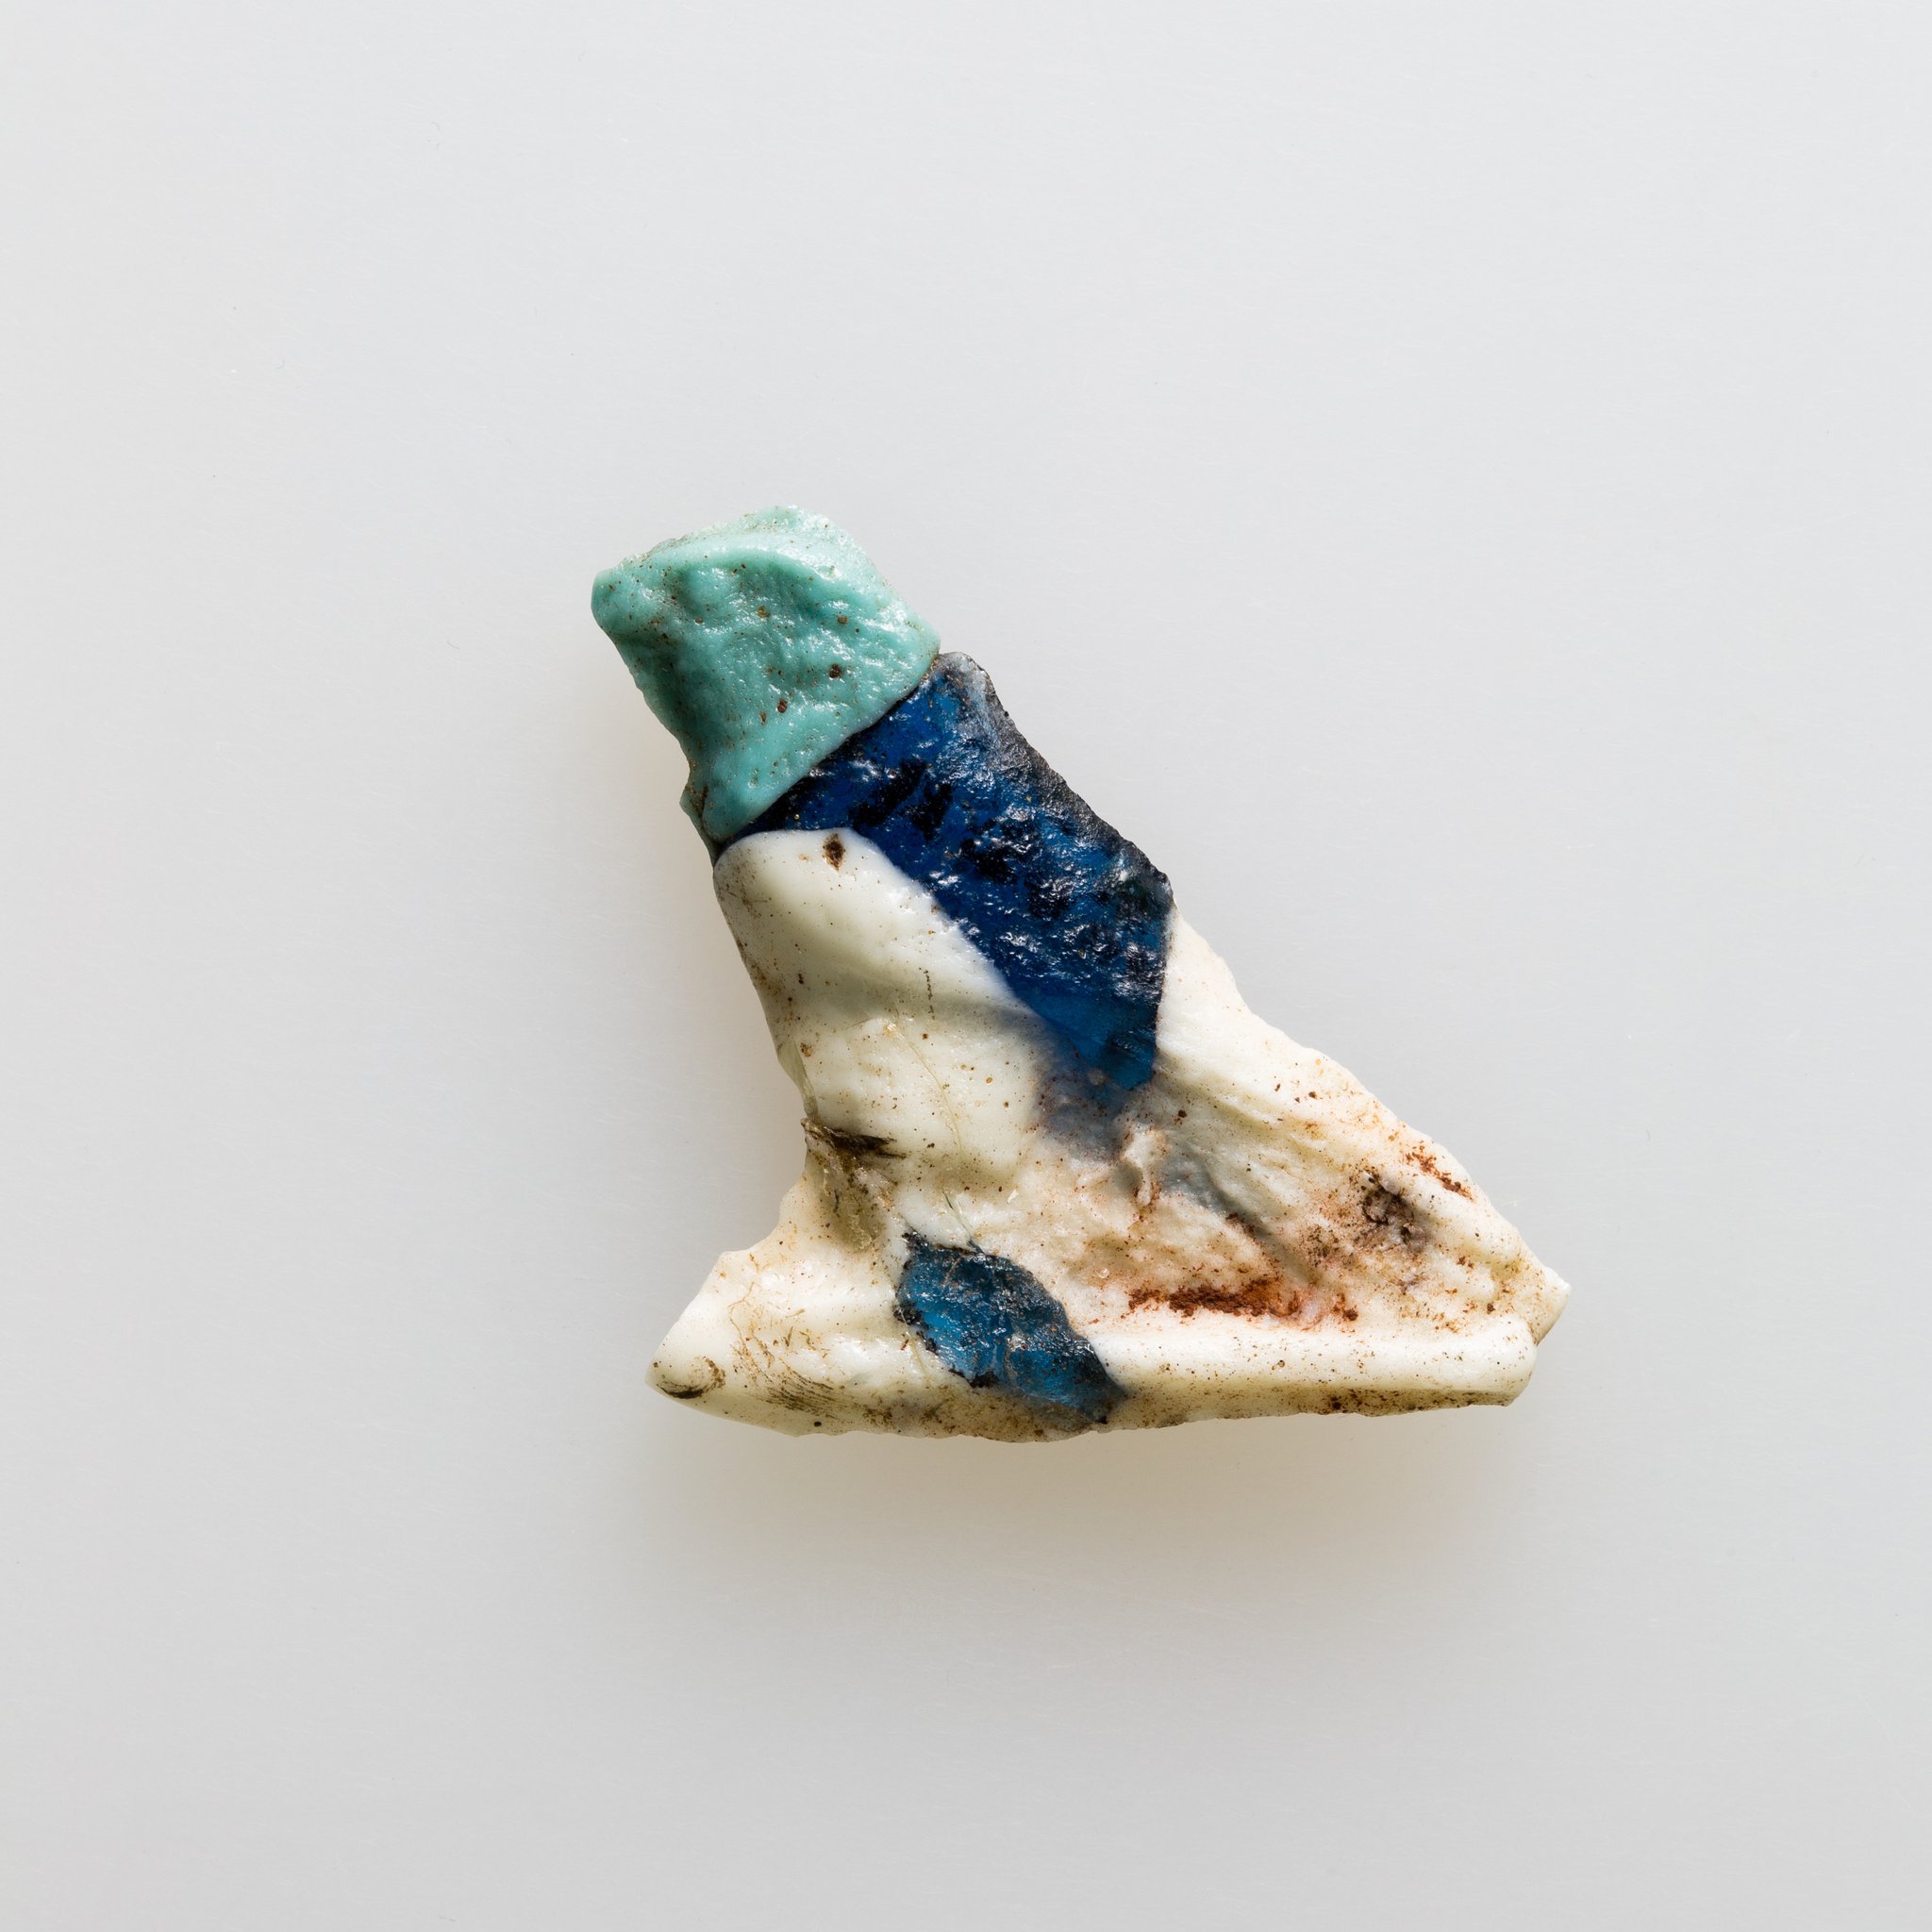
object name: amulet, falcon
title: Falcon amulet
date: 400-30 BCE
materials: glass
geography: egypt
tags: falcons